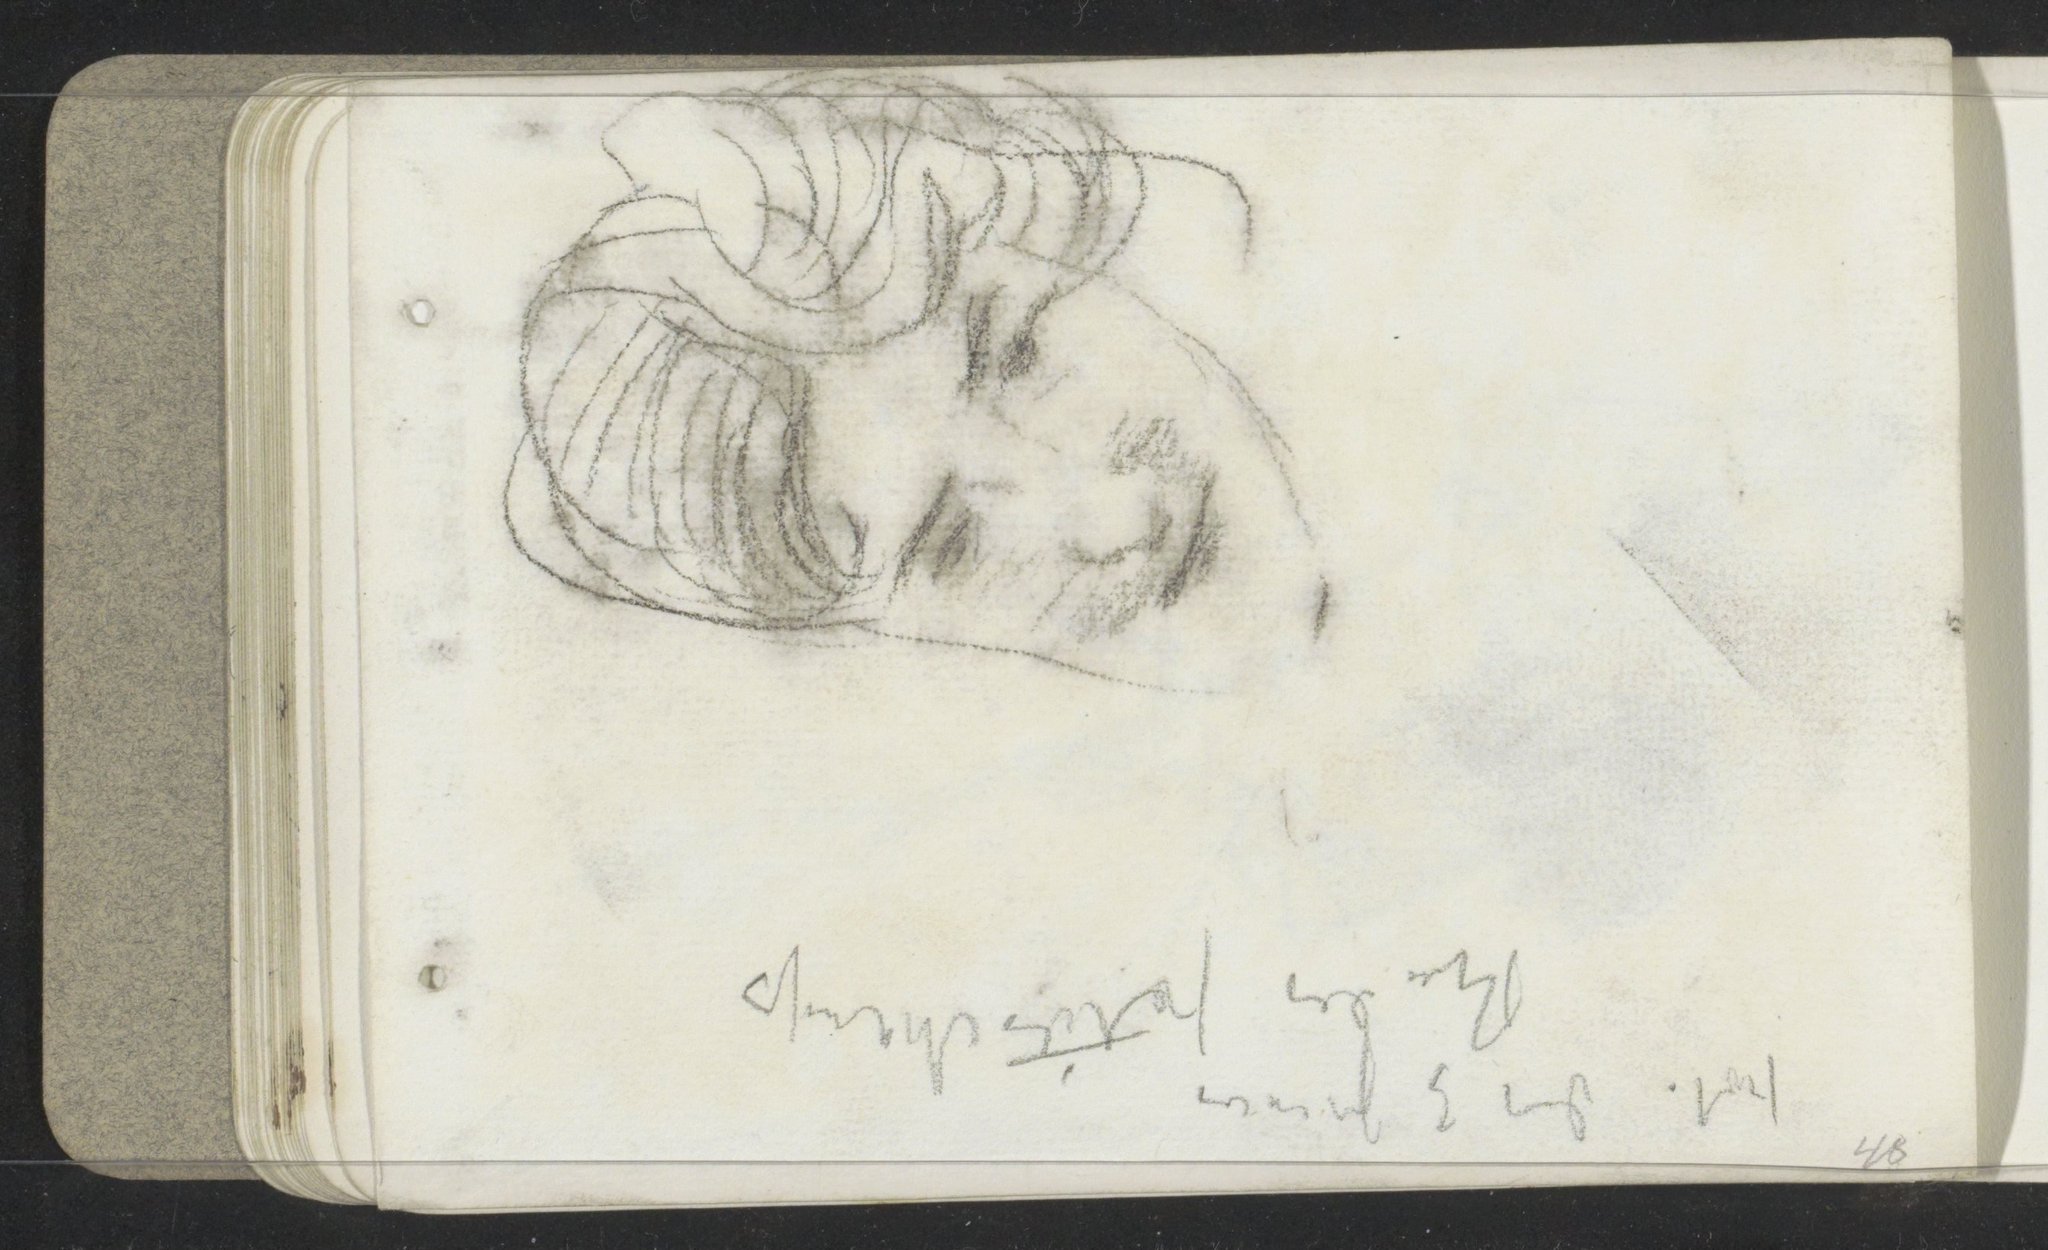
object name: sketchbook leaf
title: Vrouwenhoofd, mogelijk op een kussen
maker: isaac israels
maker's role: draughtsman, painter, print maker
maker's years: 1865-1934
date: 1875-1934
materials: chalk, paper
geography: the hague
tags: lying figure - aa - female human figure, head (human) - aa - female human figure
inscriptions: annotation: ‘[...] / Rue des petits champs’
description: Blad 19 verso uit schetsboek LX met 33 bladen.